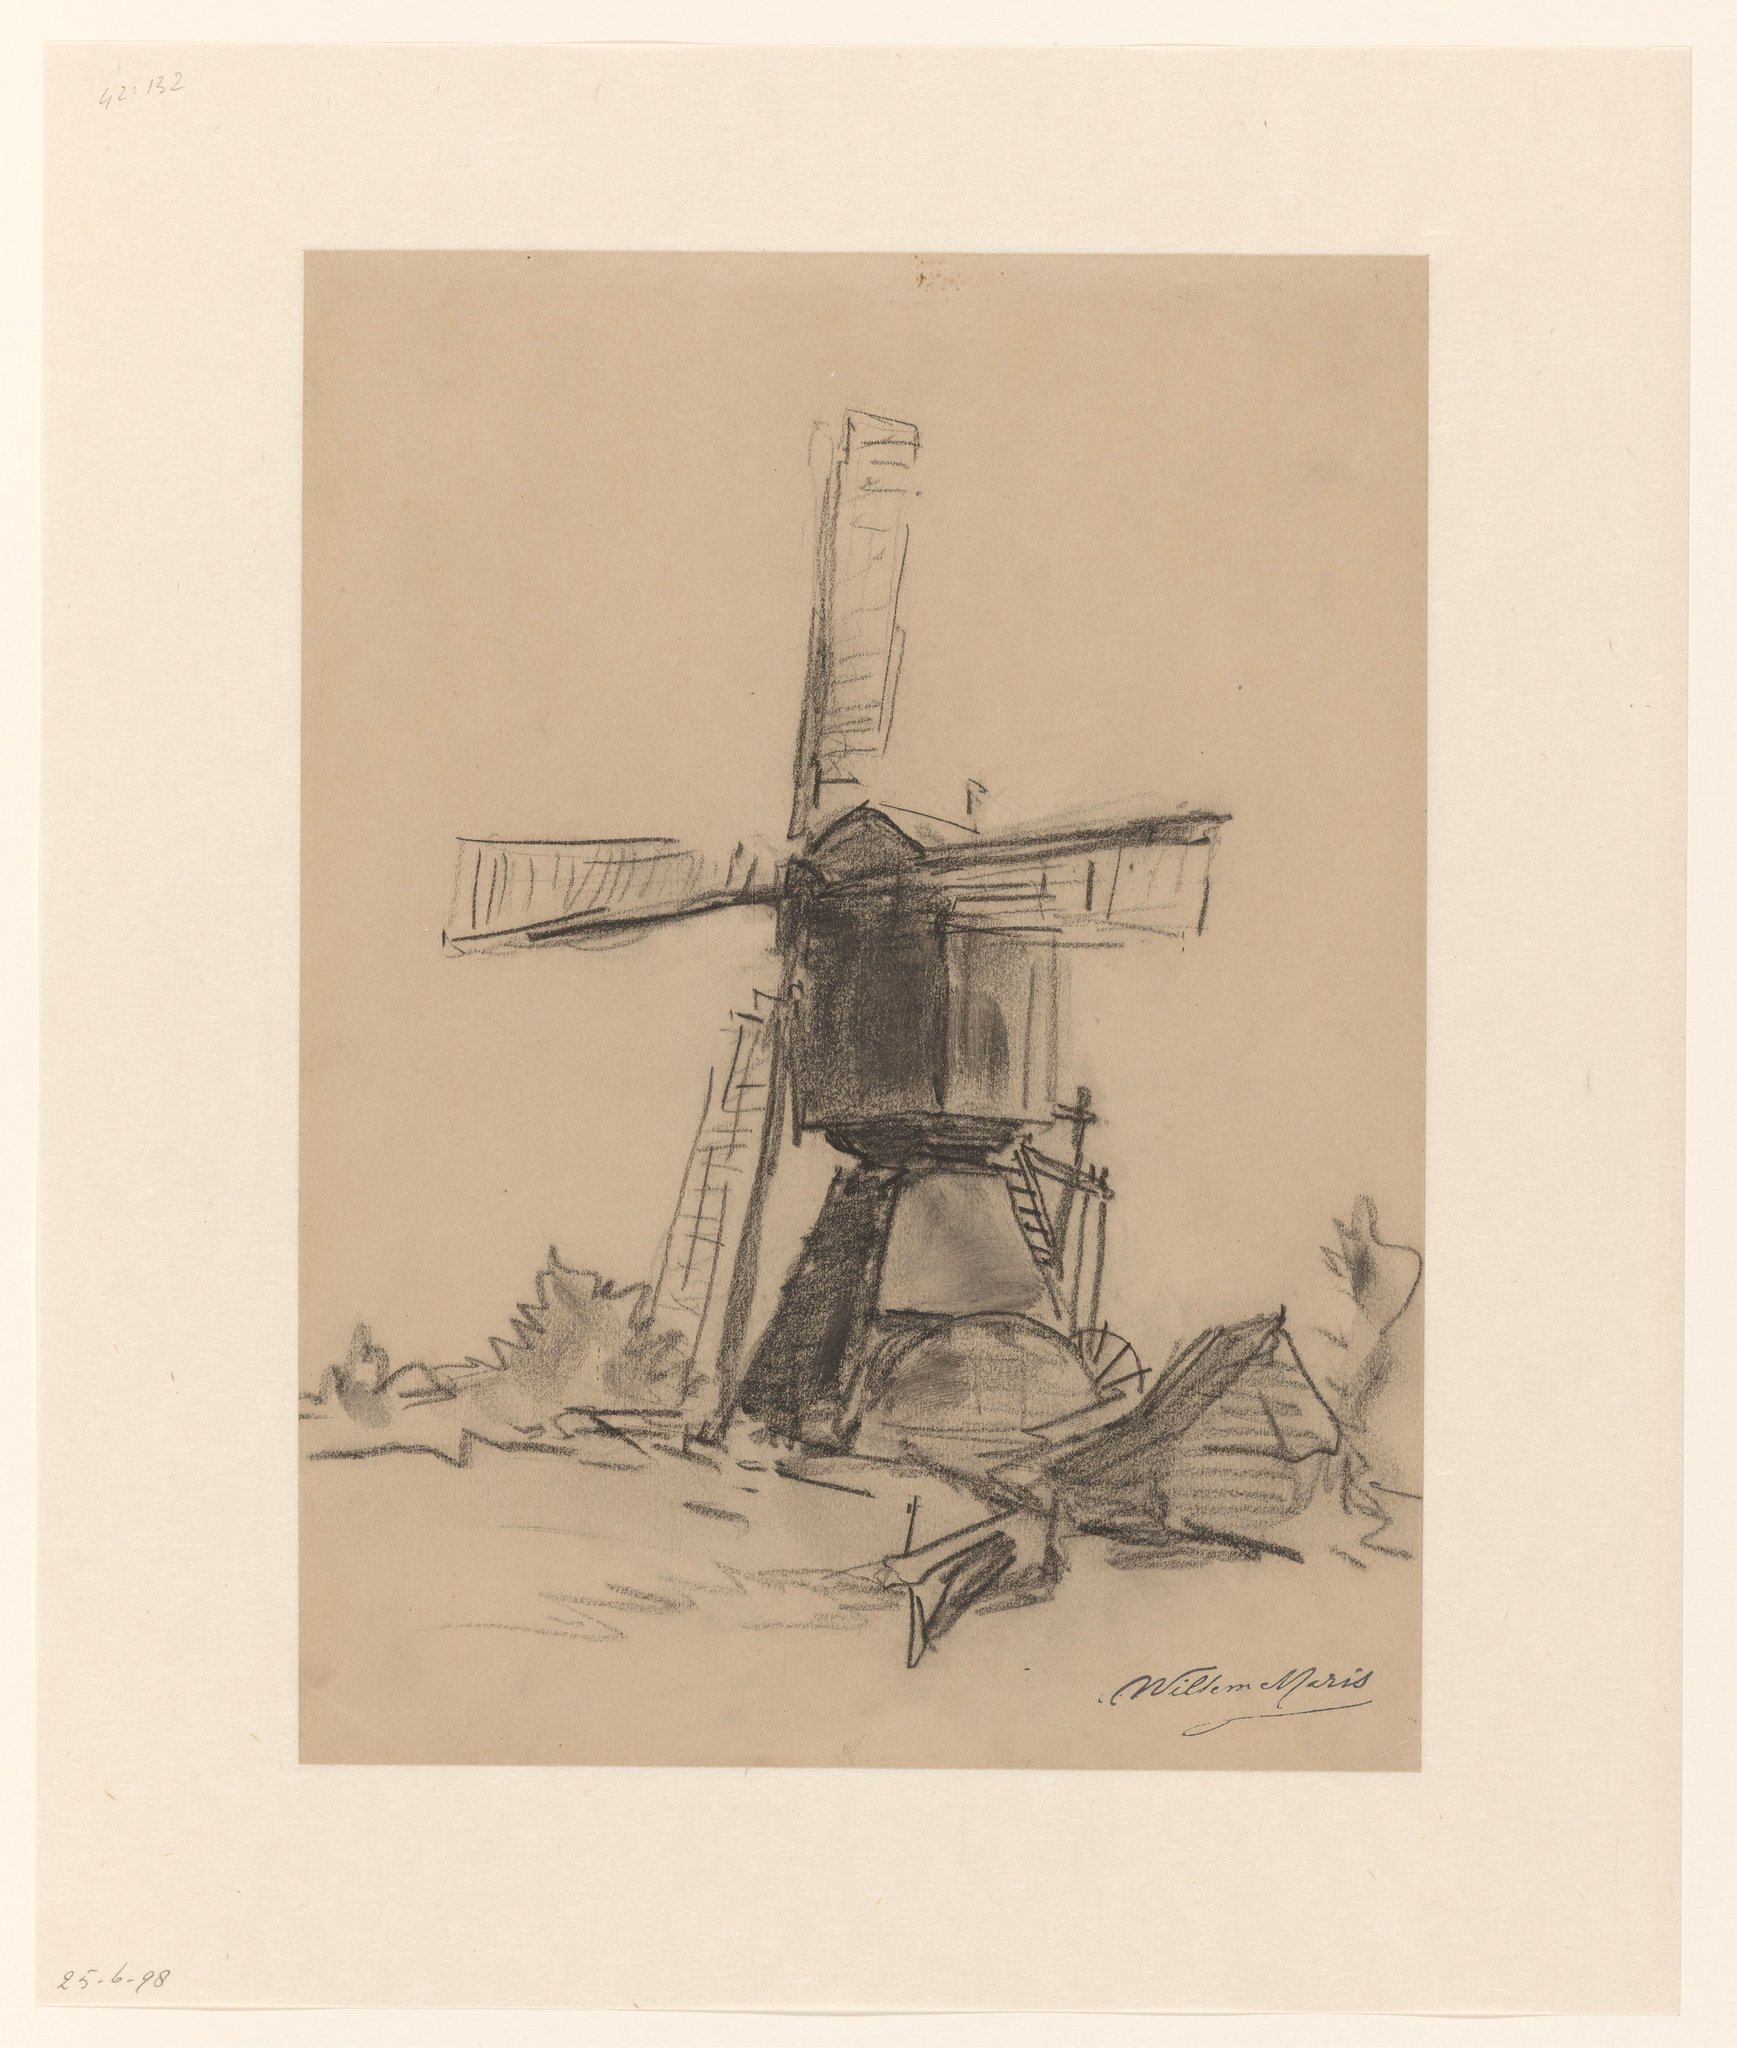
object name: drawing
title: Windmolen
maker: willem maris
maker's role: draughtsman, painter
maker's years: 1844-1910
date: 1854-1910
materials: chalk, paper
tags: watermill